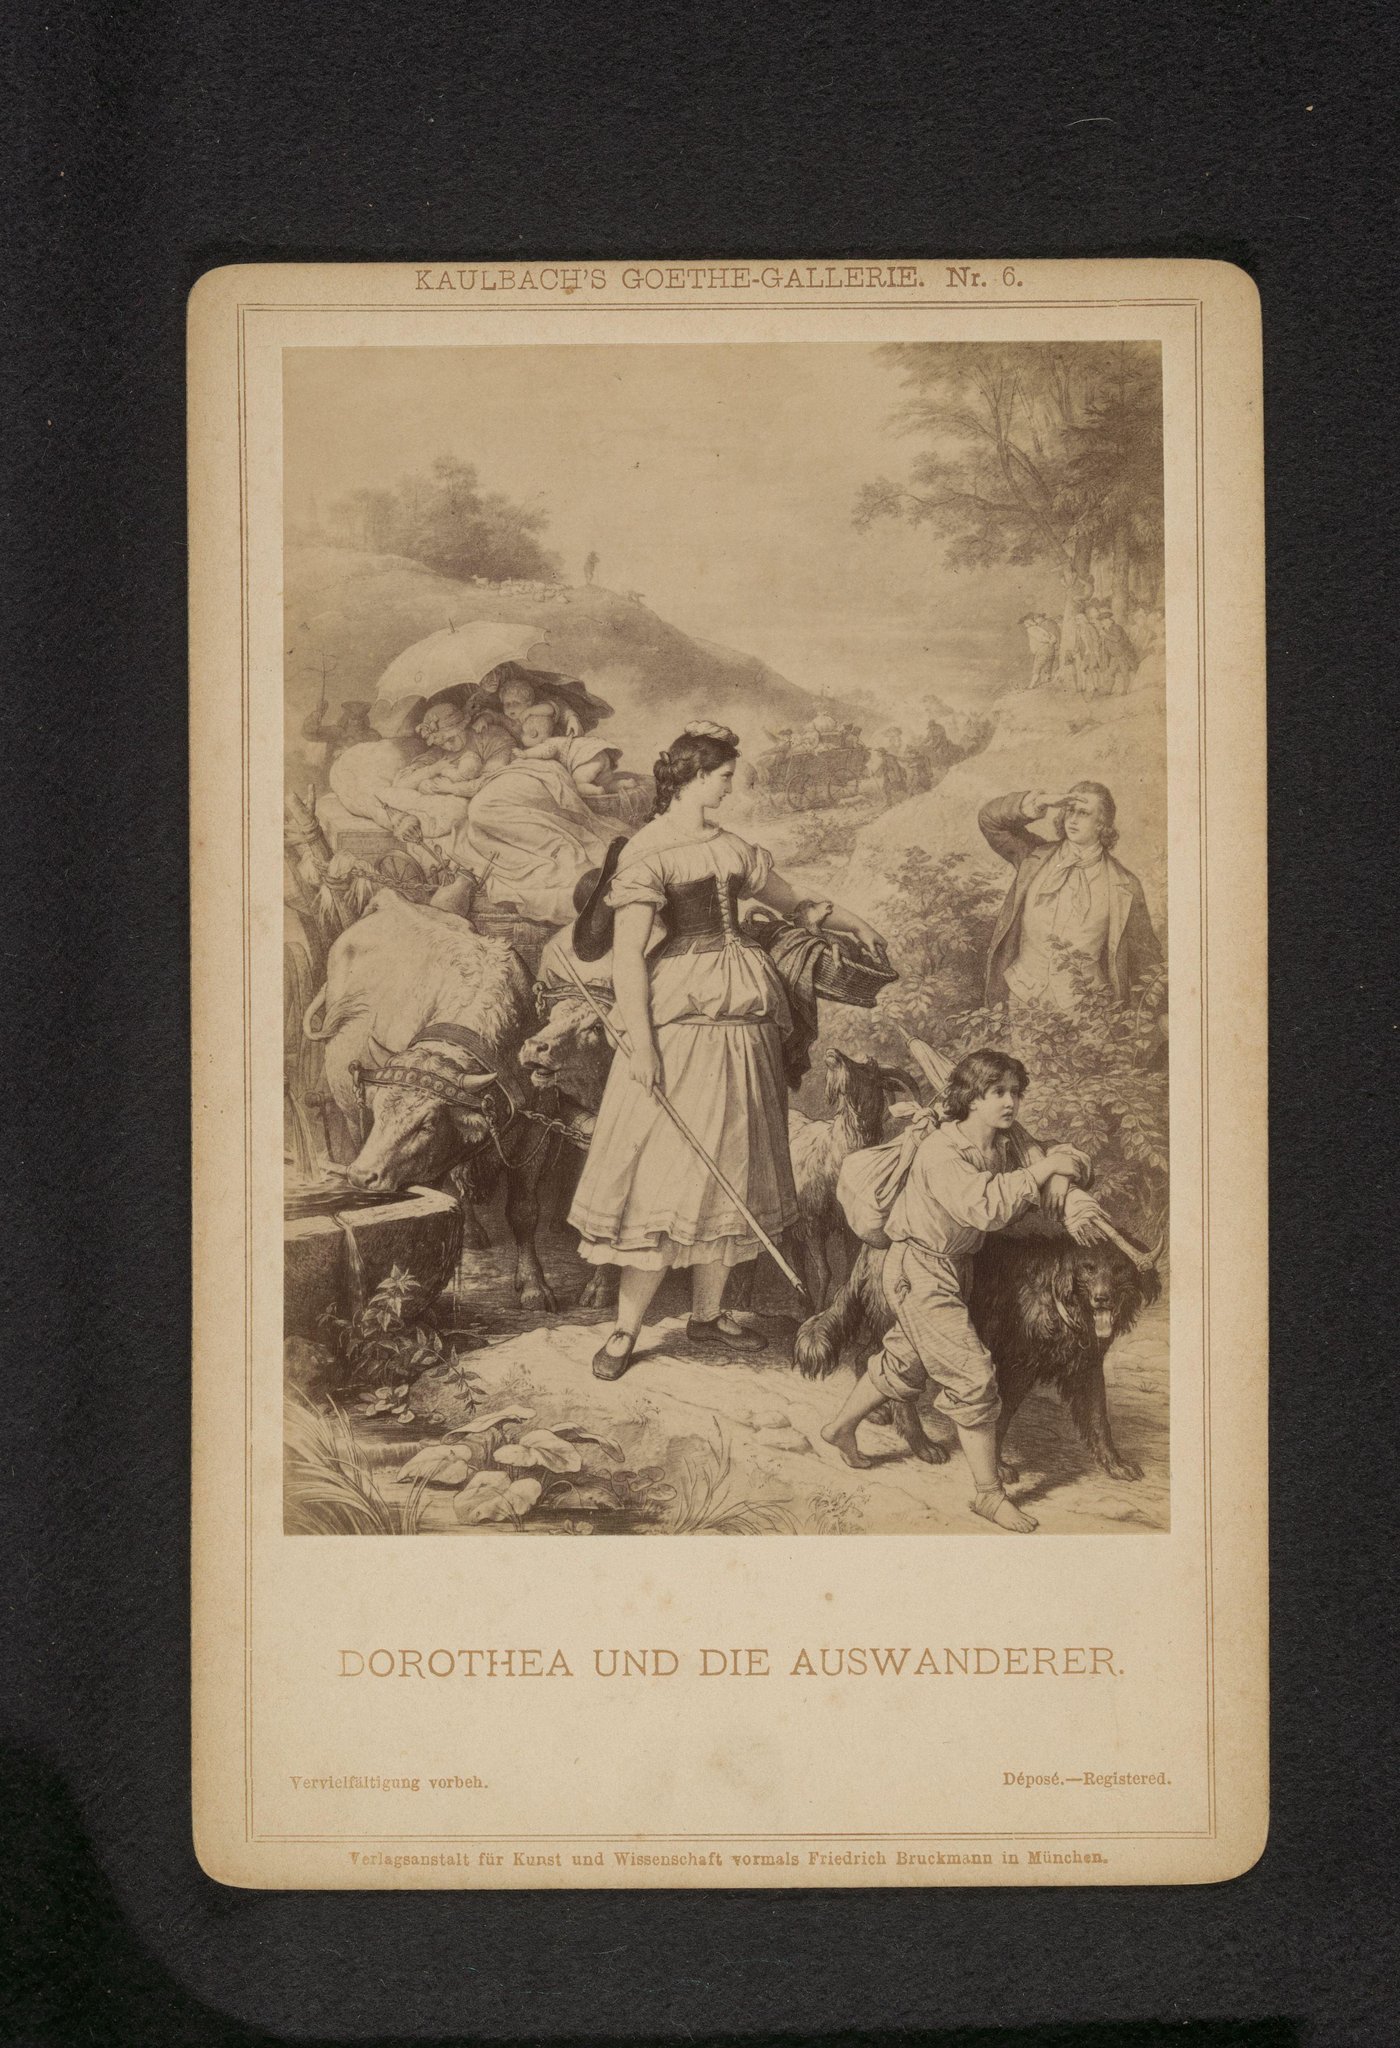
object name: reproduction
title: Fotoreproductie van een scène uit Goethe's Herman en Dorothea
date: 1880-1885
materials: photographic support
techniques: albumen print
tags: adult man, literary characters and objects, painting, drawing and the graphic arts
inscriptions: inscription: ‘Vervielfältigung vorbeh. Déposé - Registered./ Verlagsanstalt für Kunst und Wissenschaft vormals Friedrich Bruckmann in München.’, name: ‘Friedrich Bruckmann's Verlag/ München’, inscription: ‘Kaulbach's Goethe-Gallerie Nr. 6’, annotation: ‘24.12.94’